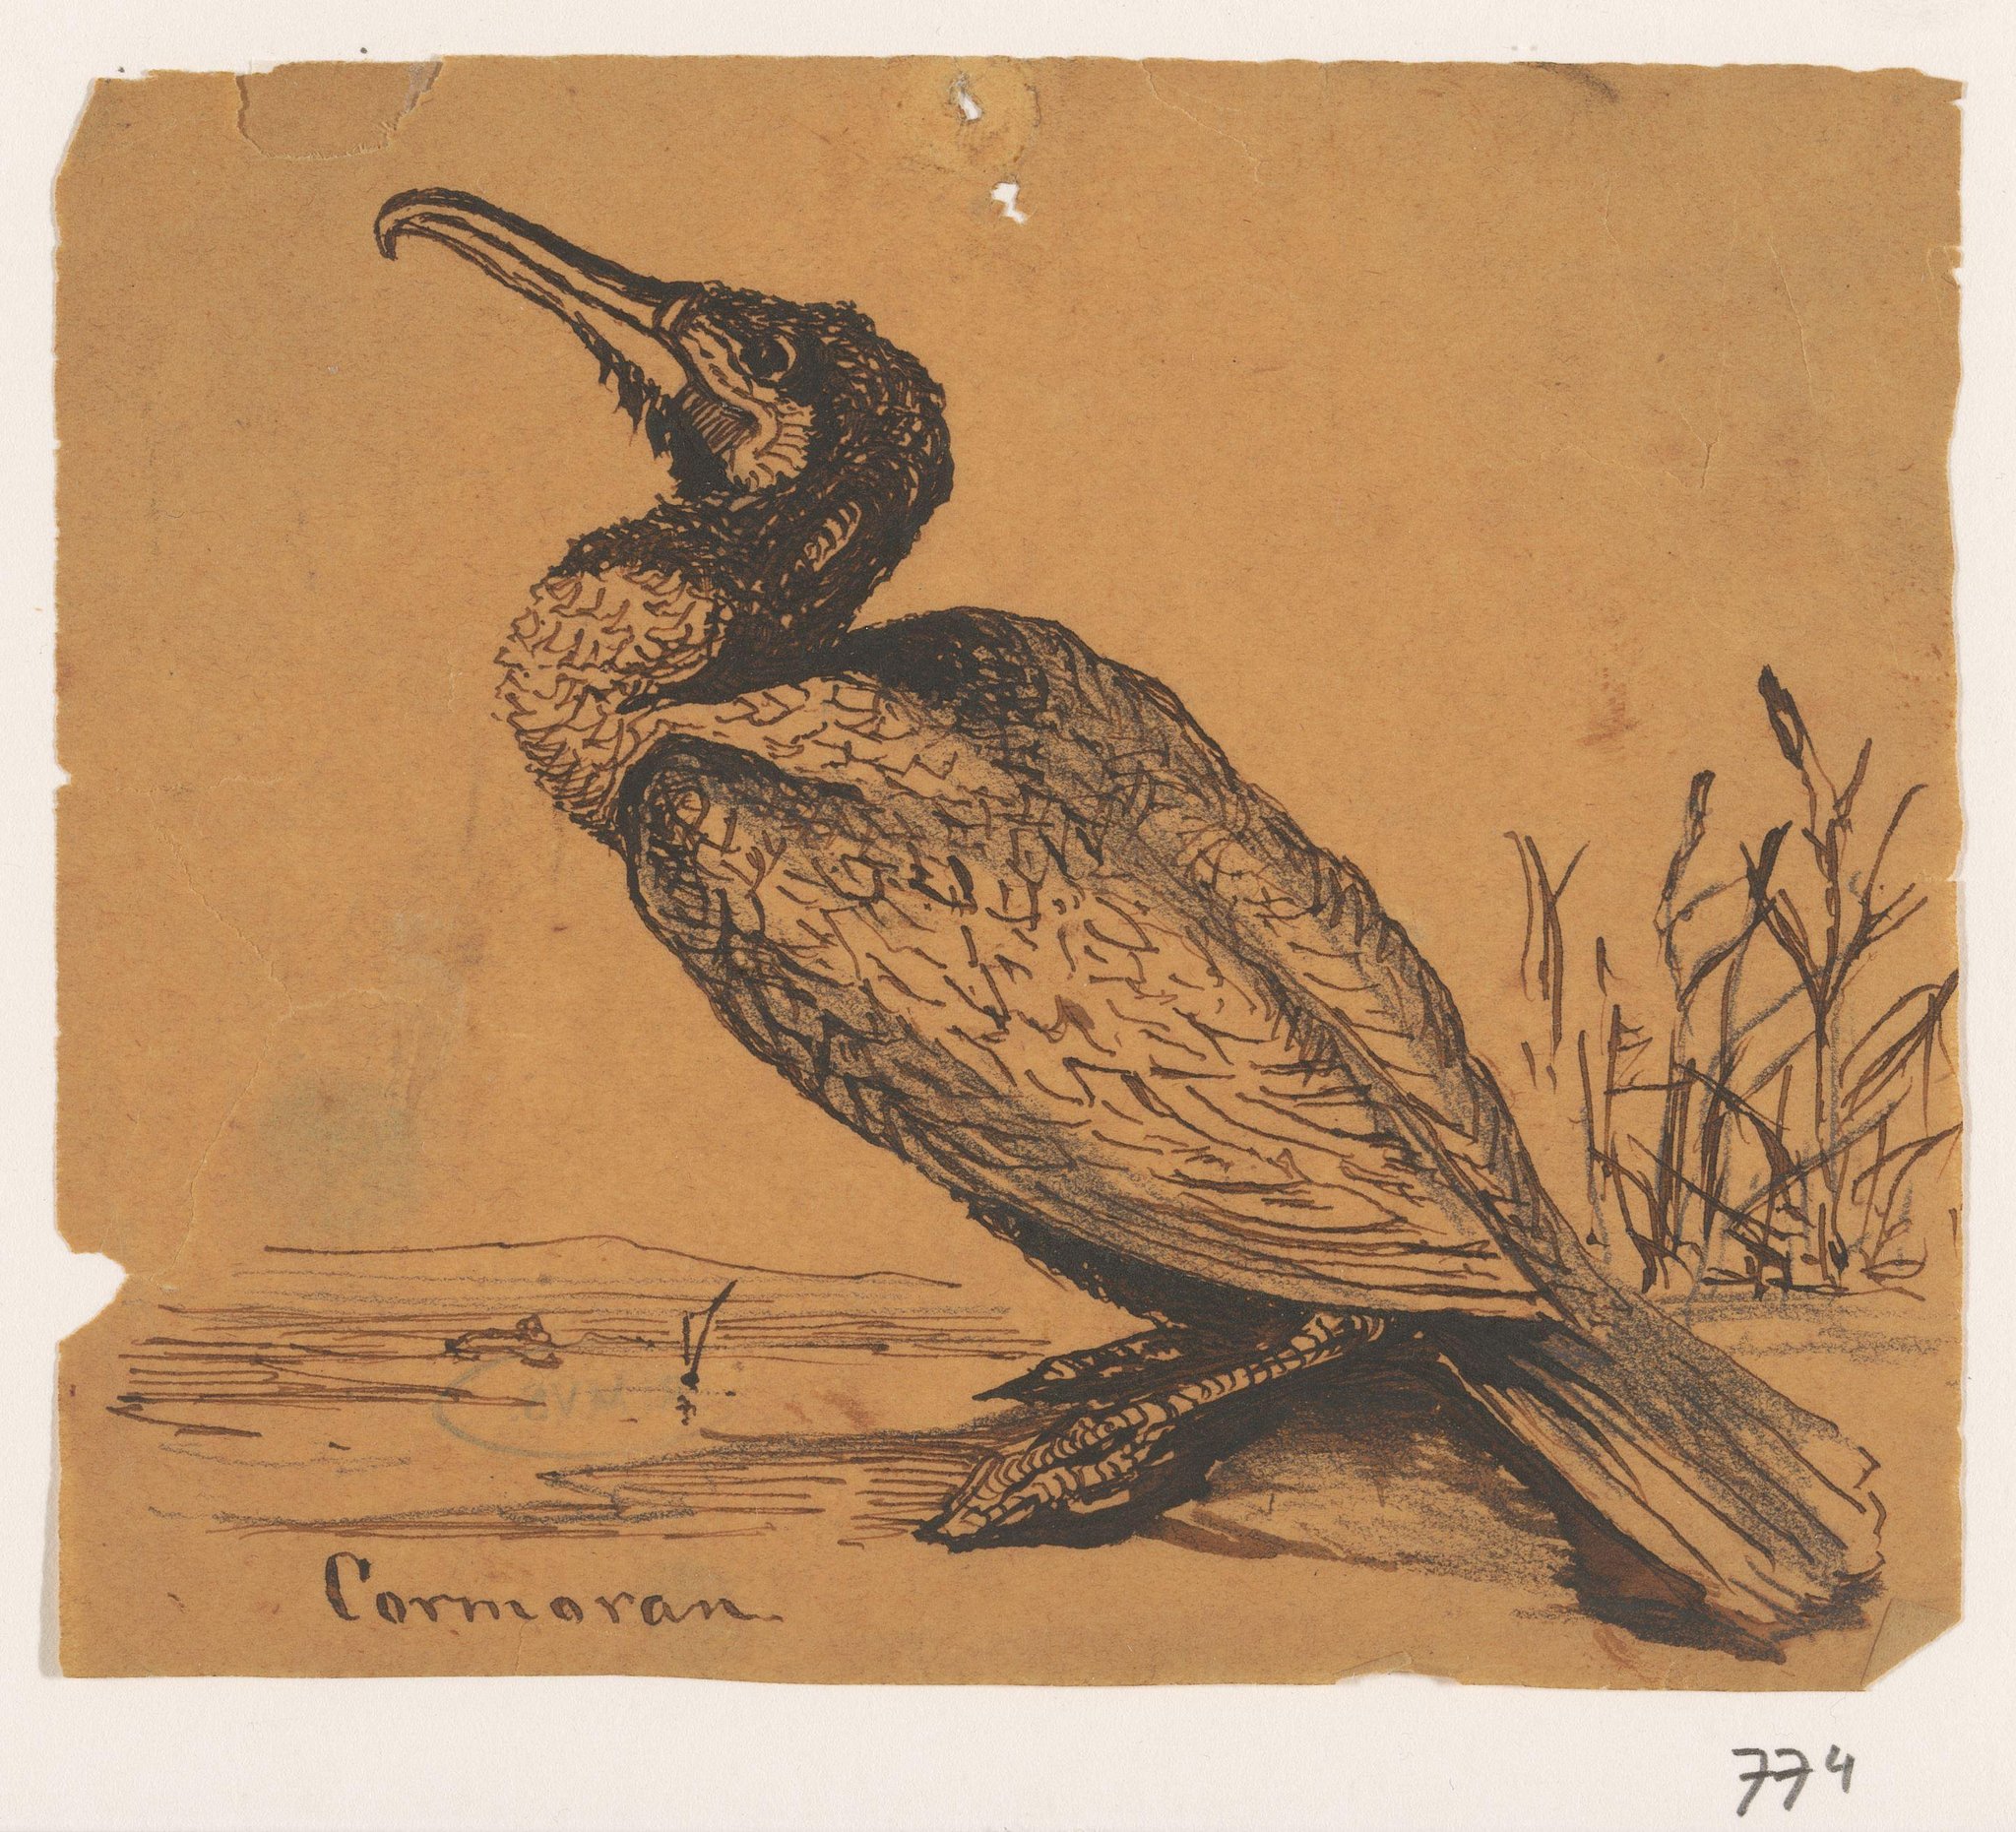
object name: drawing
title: Aalscholver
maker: johannes tavenraat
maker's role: draughtsman, painter, print maker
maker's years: 1809-1881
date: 1840-1880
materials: ink, paper, pencil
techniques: brush, pen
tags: water-birds: cormorant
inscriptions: collector's mark: Lugt 2228